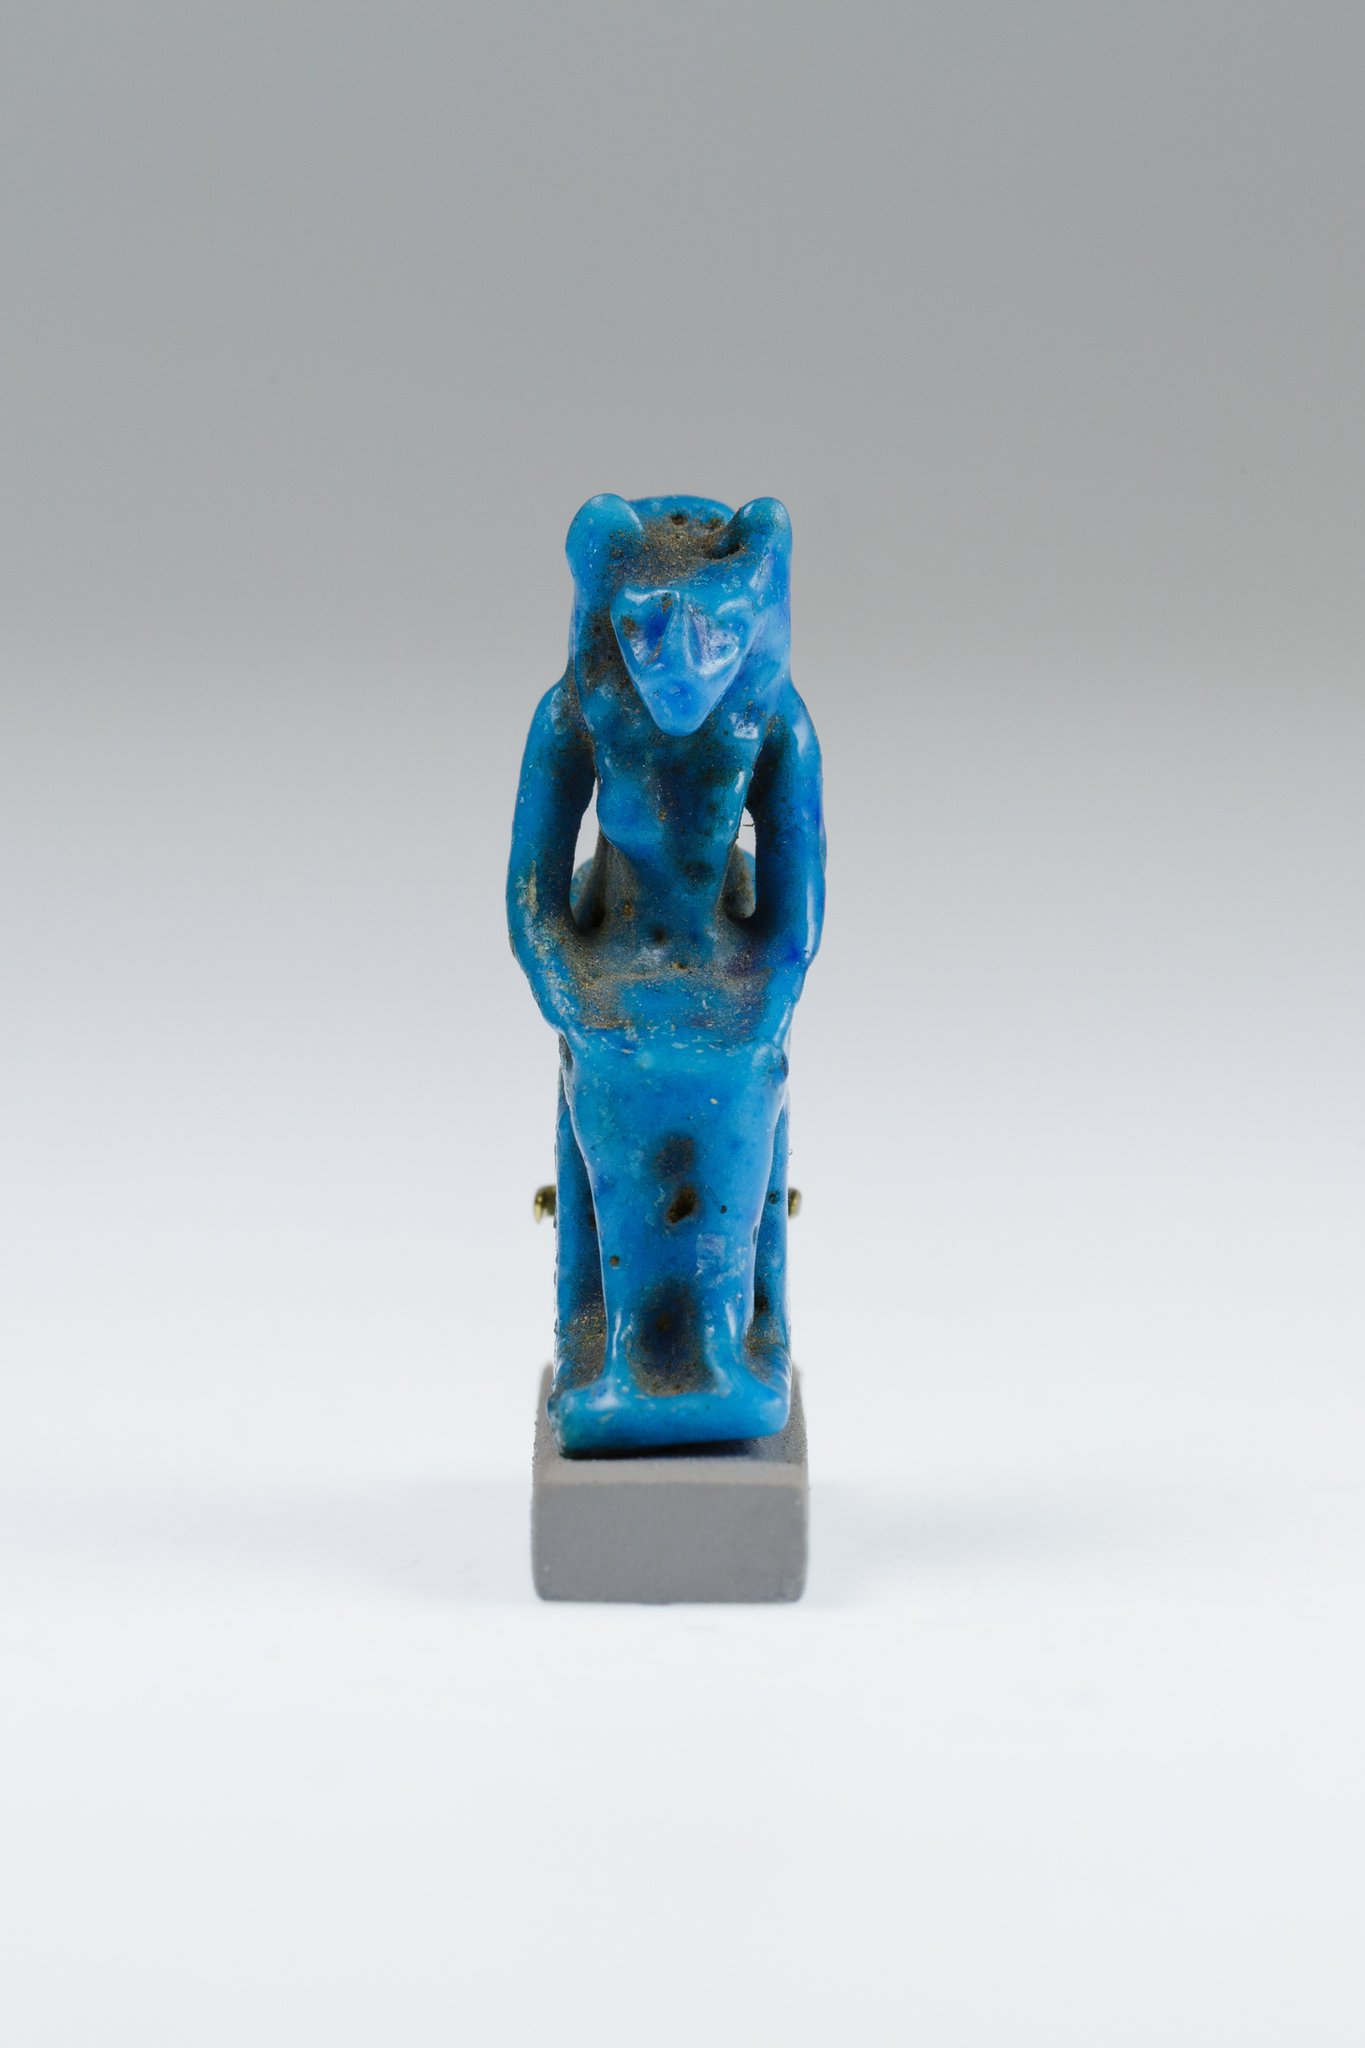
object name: amulet, sakhmet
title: Sakhmet Amulet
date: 664-525 BCE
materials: faience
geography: egypt